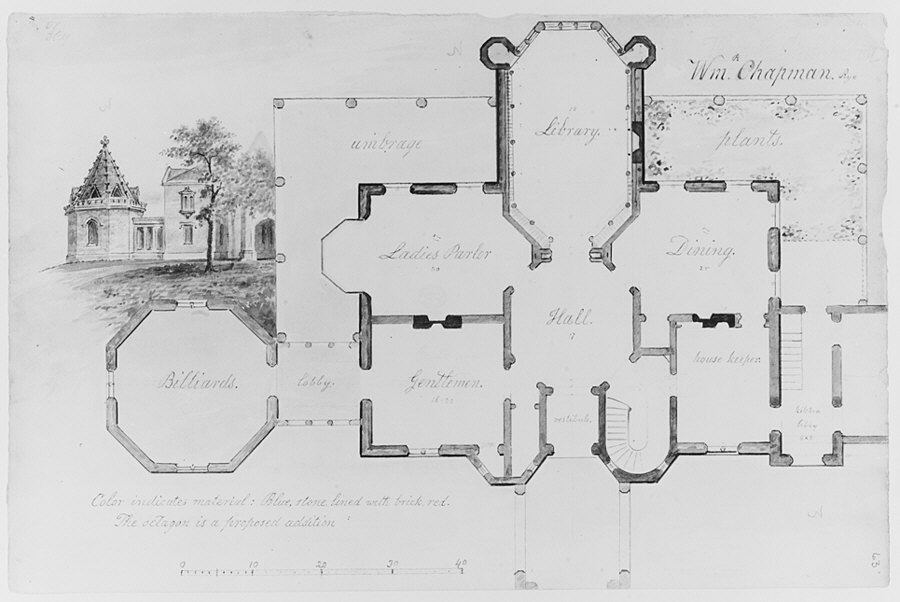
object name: drawing ornament architecture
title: Whitby, William P. Chapman House, Rye, New York (plan and partial elevation)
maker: alexander jackson davis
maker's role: artist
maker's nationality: american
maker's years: 1803-1892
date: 1853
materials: ink, watercolor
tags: architecture,houses